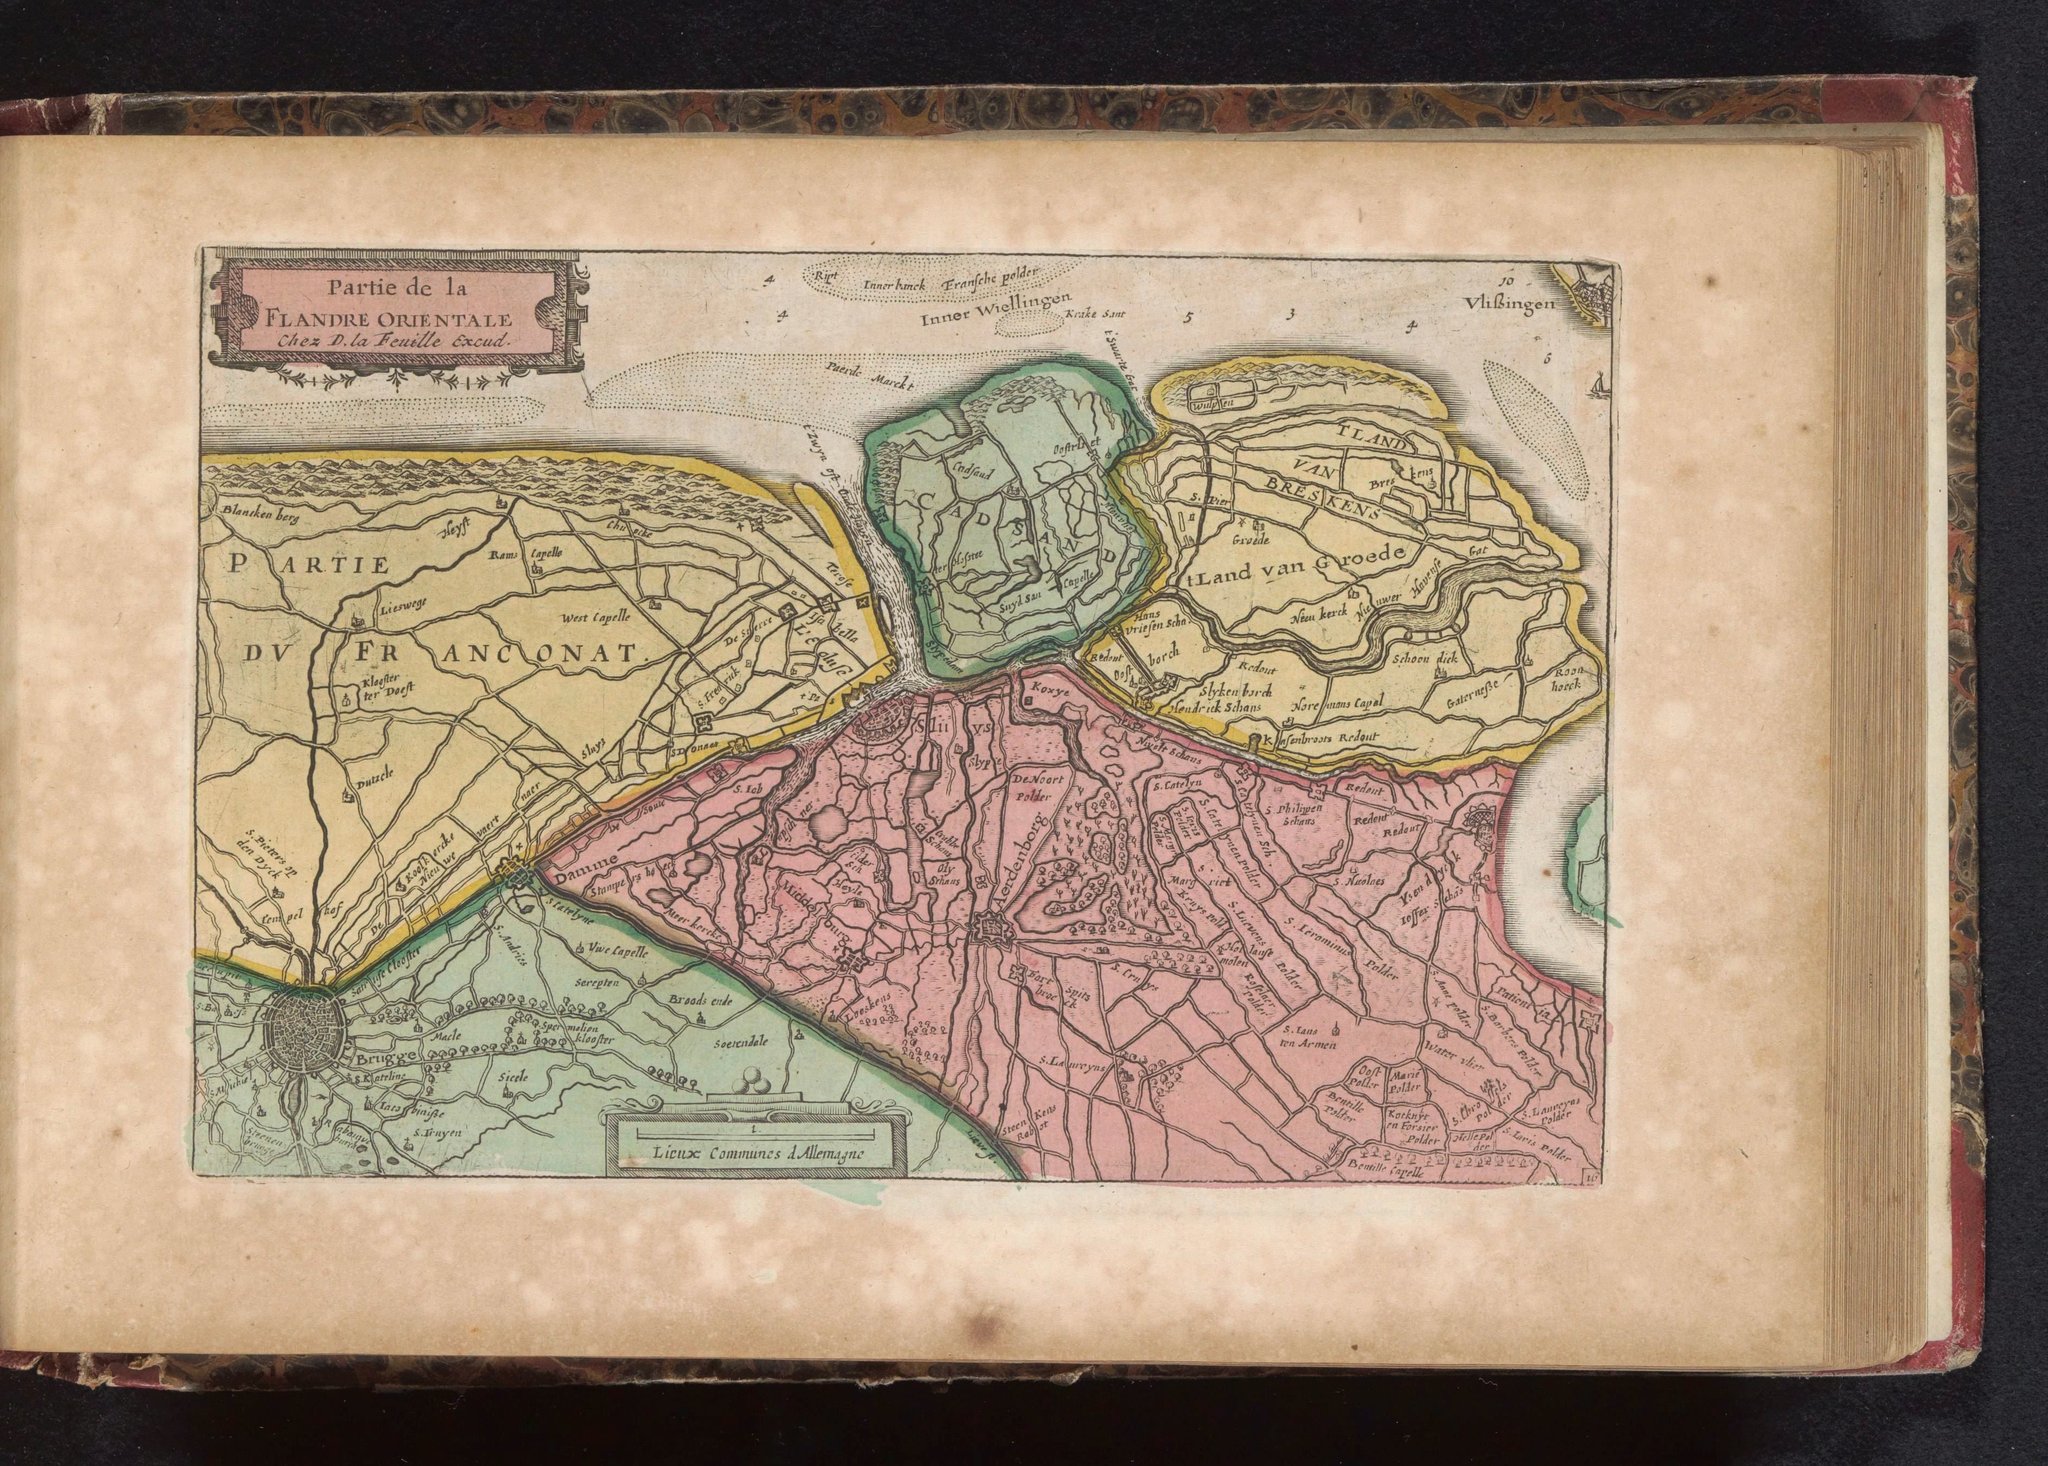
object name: print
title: Partie de la Flandre Orientale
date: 1700-1702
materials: paper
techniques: engraving, hand coloring, lacquer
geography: amsterdam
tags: maps of separate countries or regions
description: Kaart van Oost-Vlaanderen, linksonder de stad Brugge. Onderdeel van een atlas met 223 kaarten van landen en steden en oorlogstaferelen in Europa in de periode ca. 1690-1735.